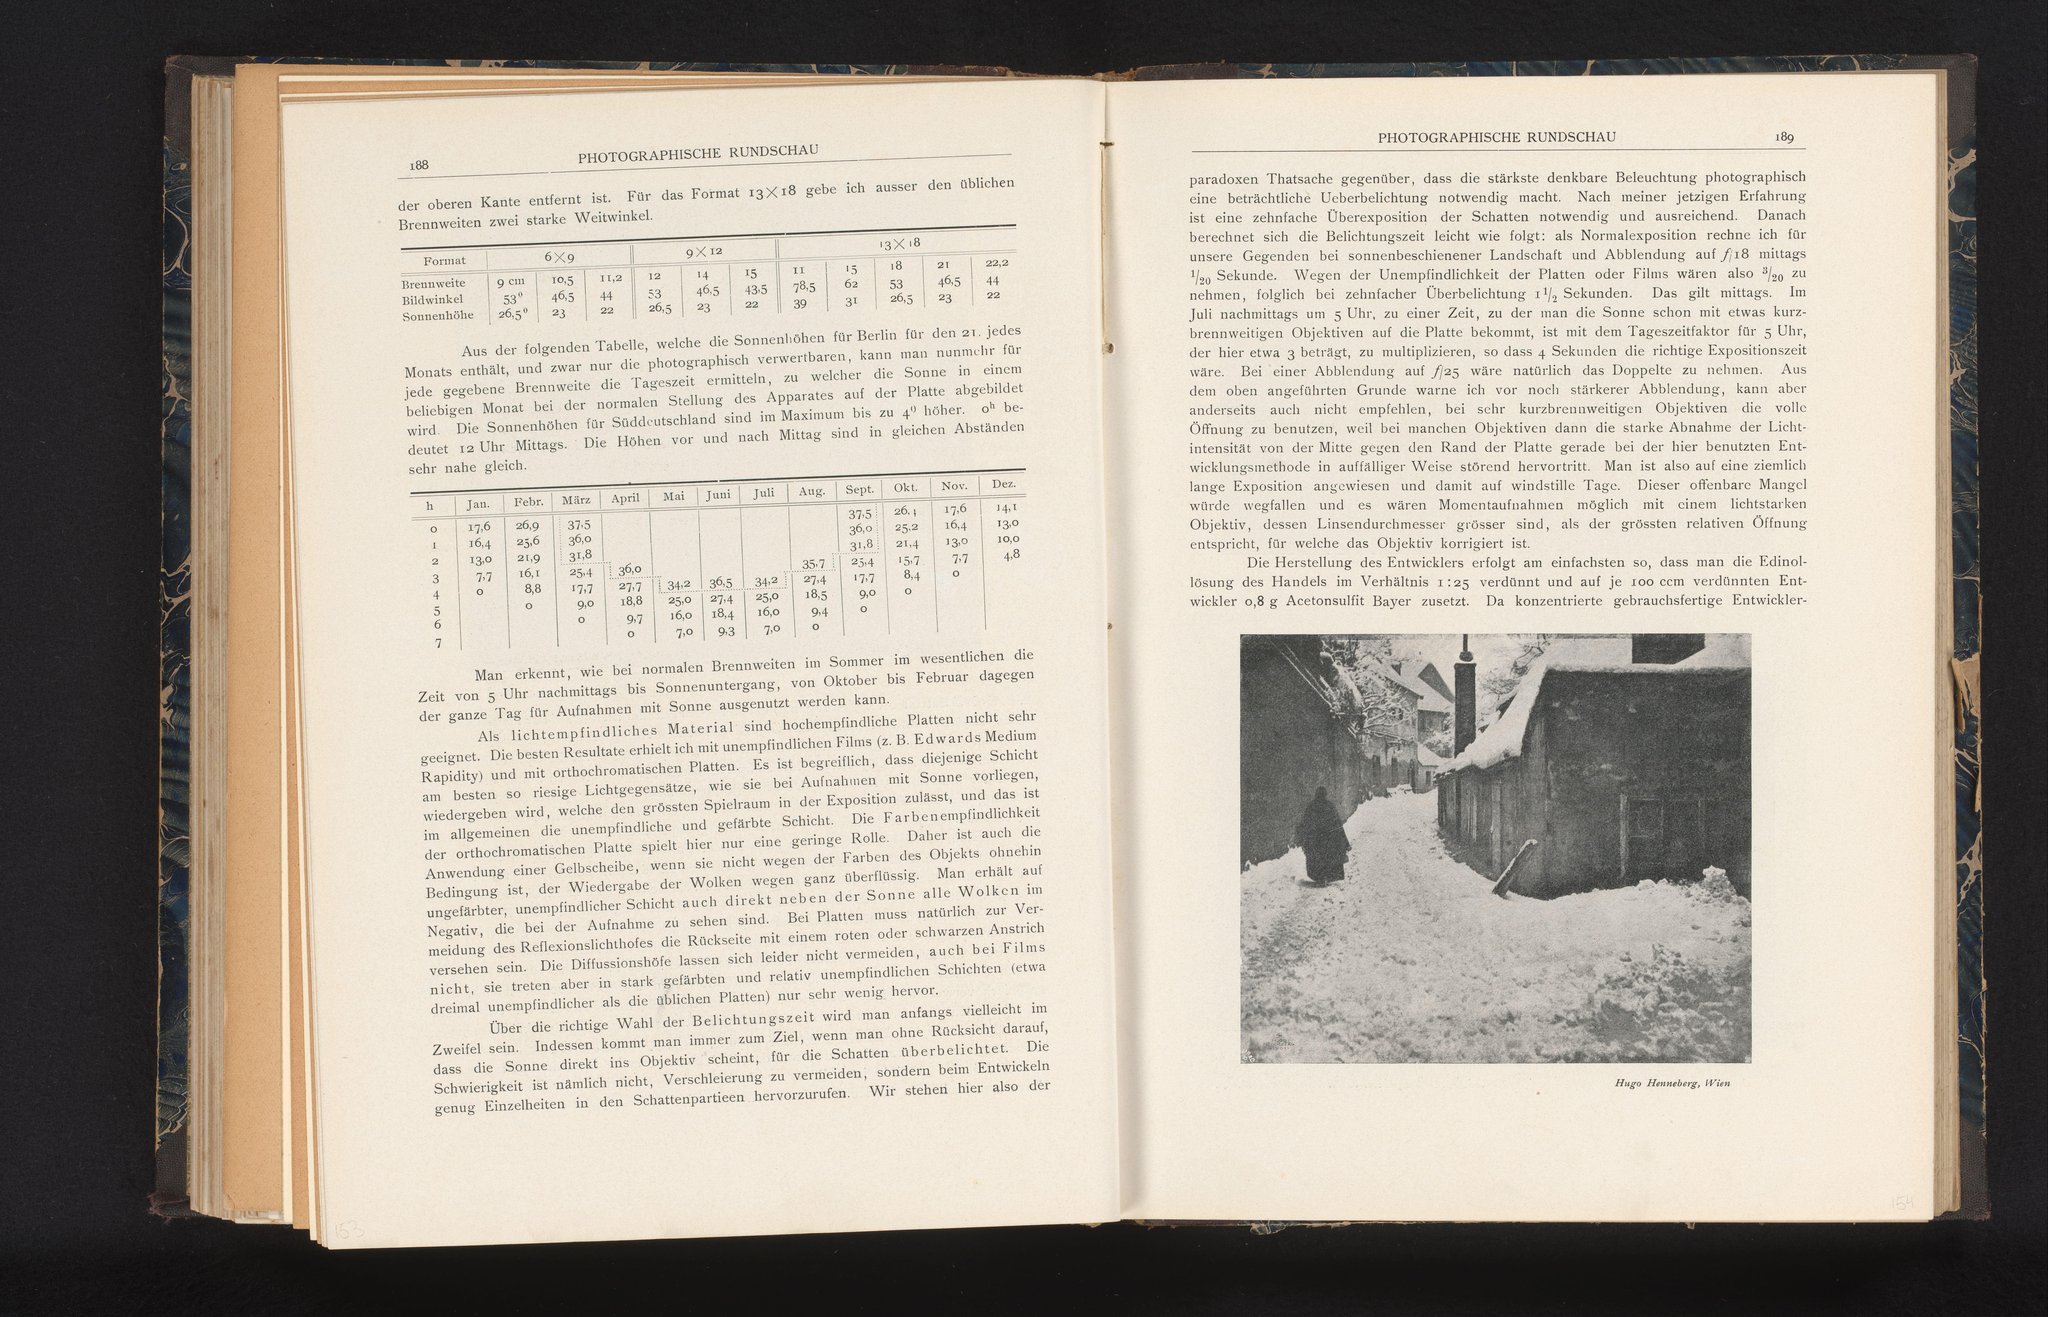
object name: page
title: Gezicht op een besneeuwde straat met een onbekend persoon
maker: hugo henneberg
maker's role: fotograaf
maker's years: 1863-1918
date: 1897-1902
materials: paper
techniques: autotype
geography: berlin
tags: snow, street